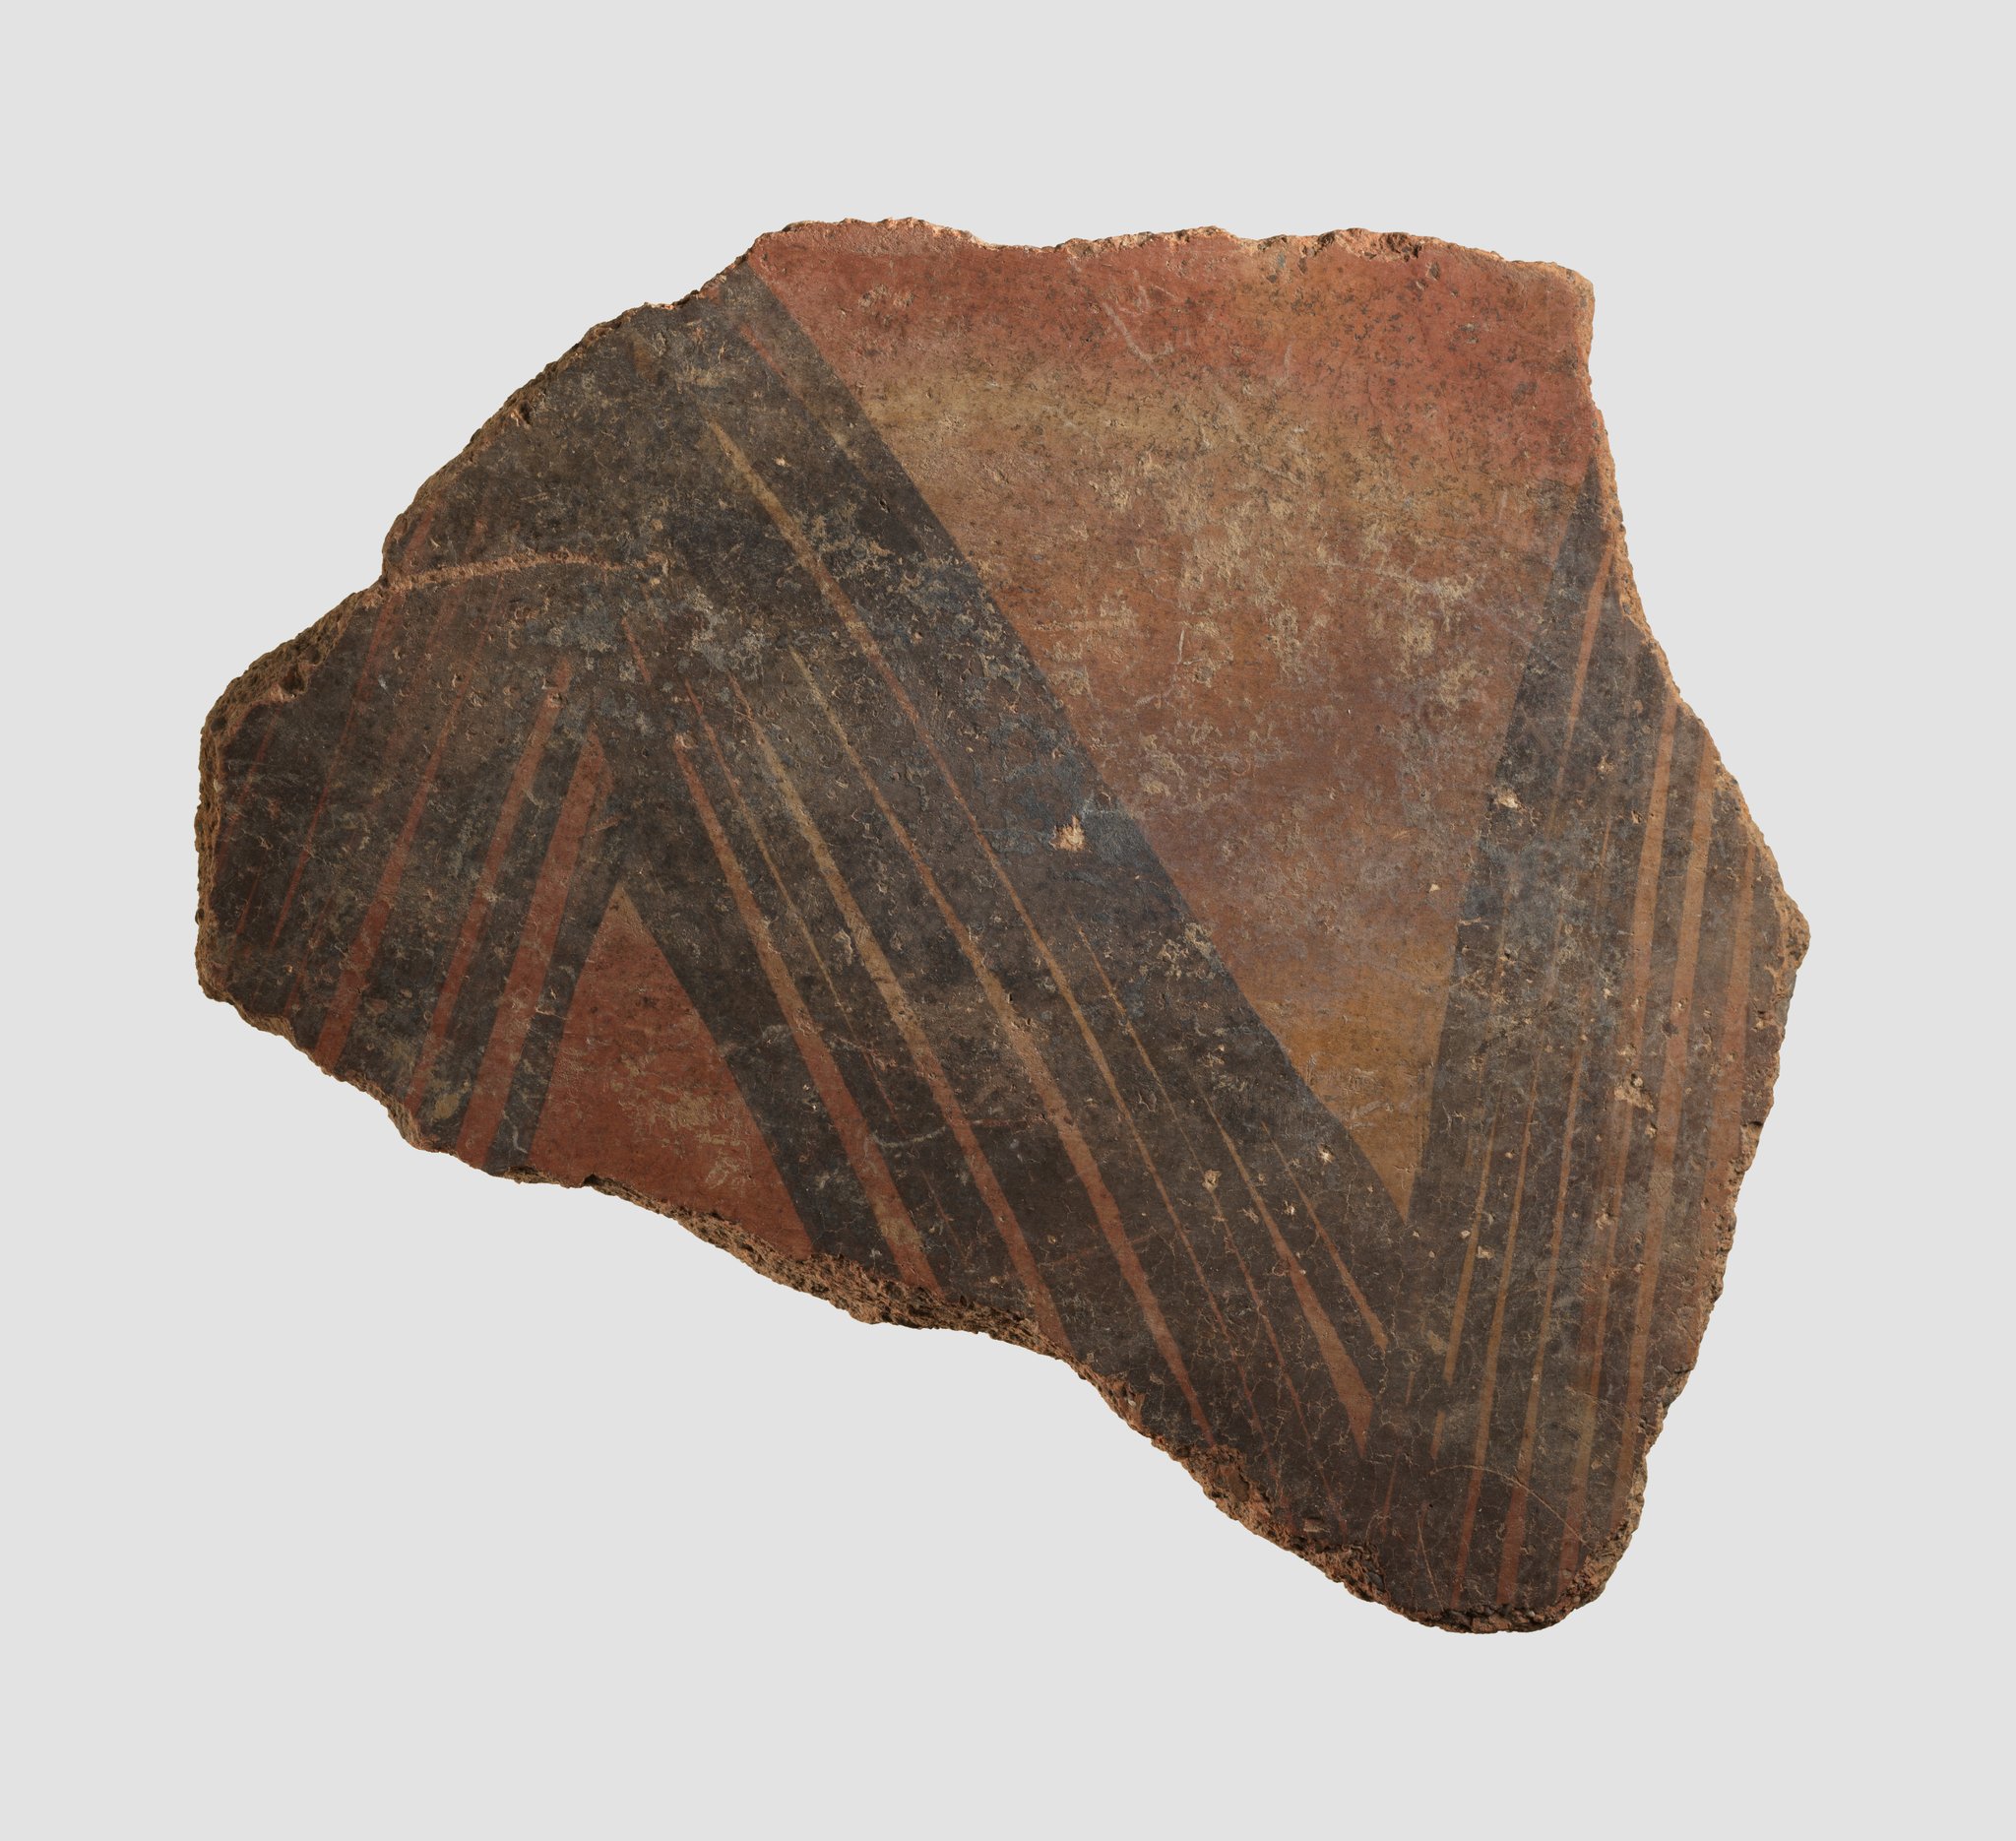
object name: sherd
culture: iranian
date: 3500-3100 BCE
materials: ceramic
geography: iran